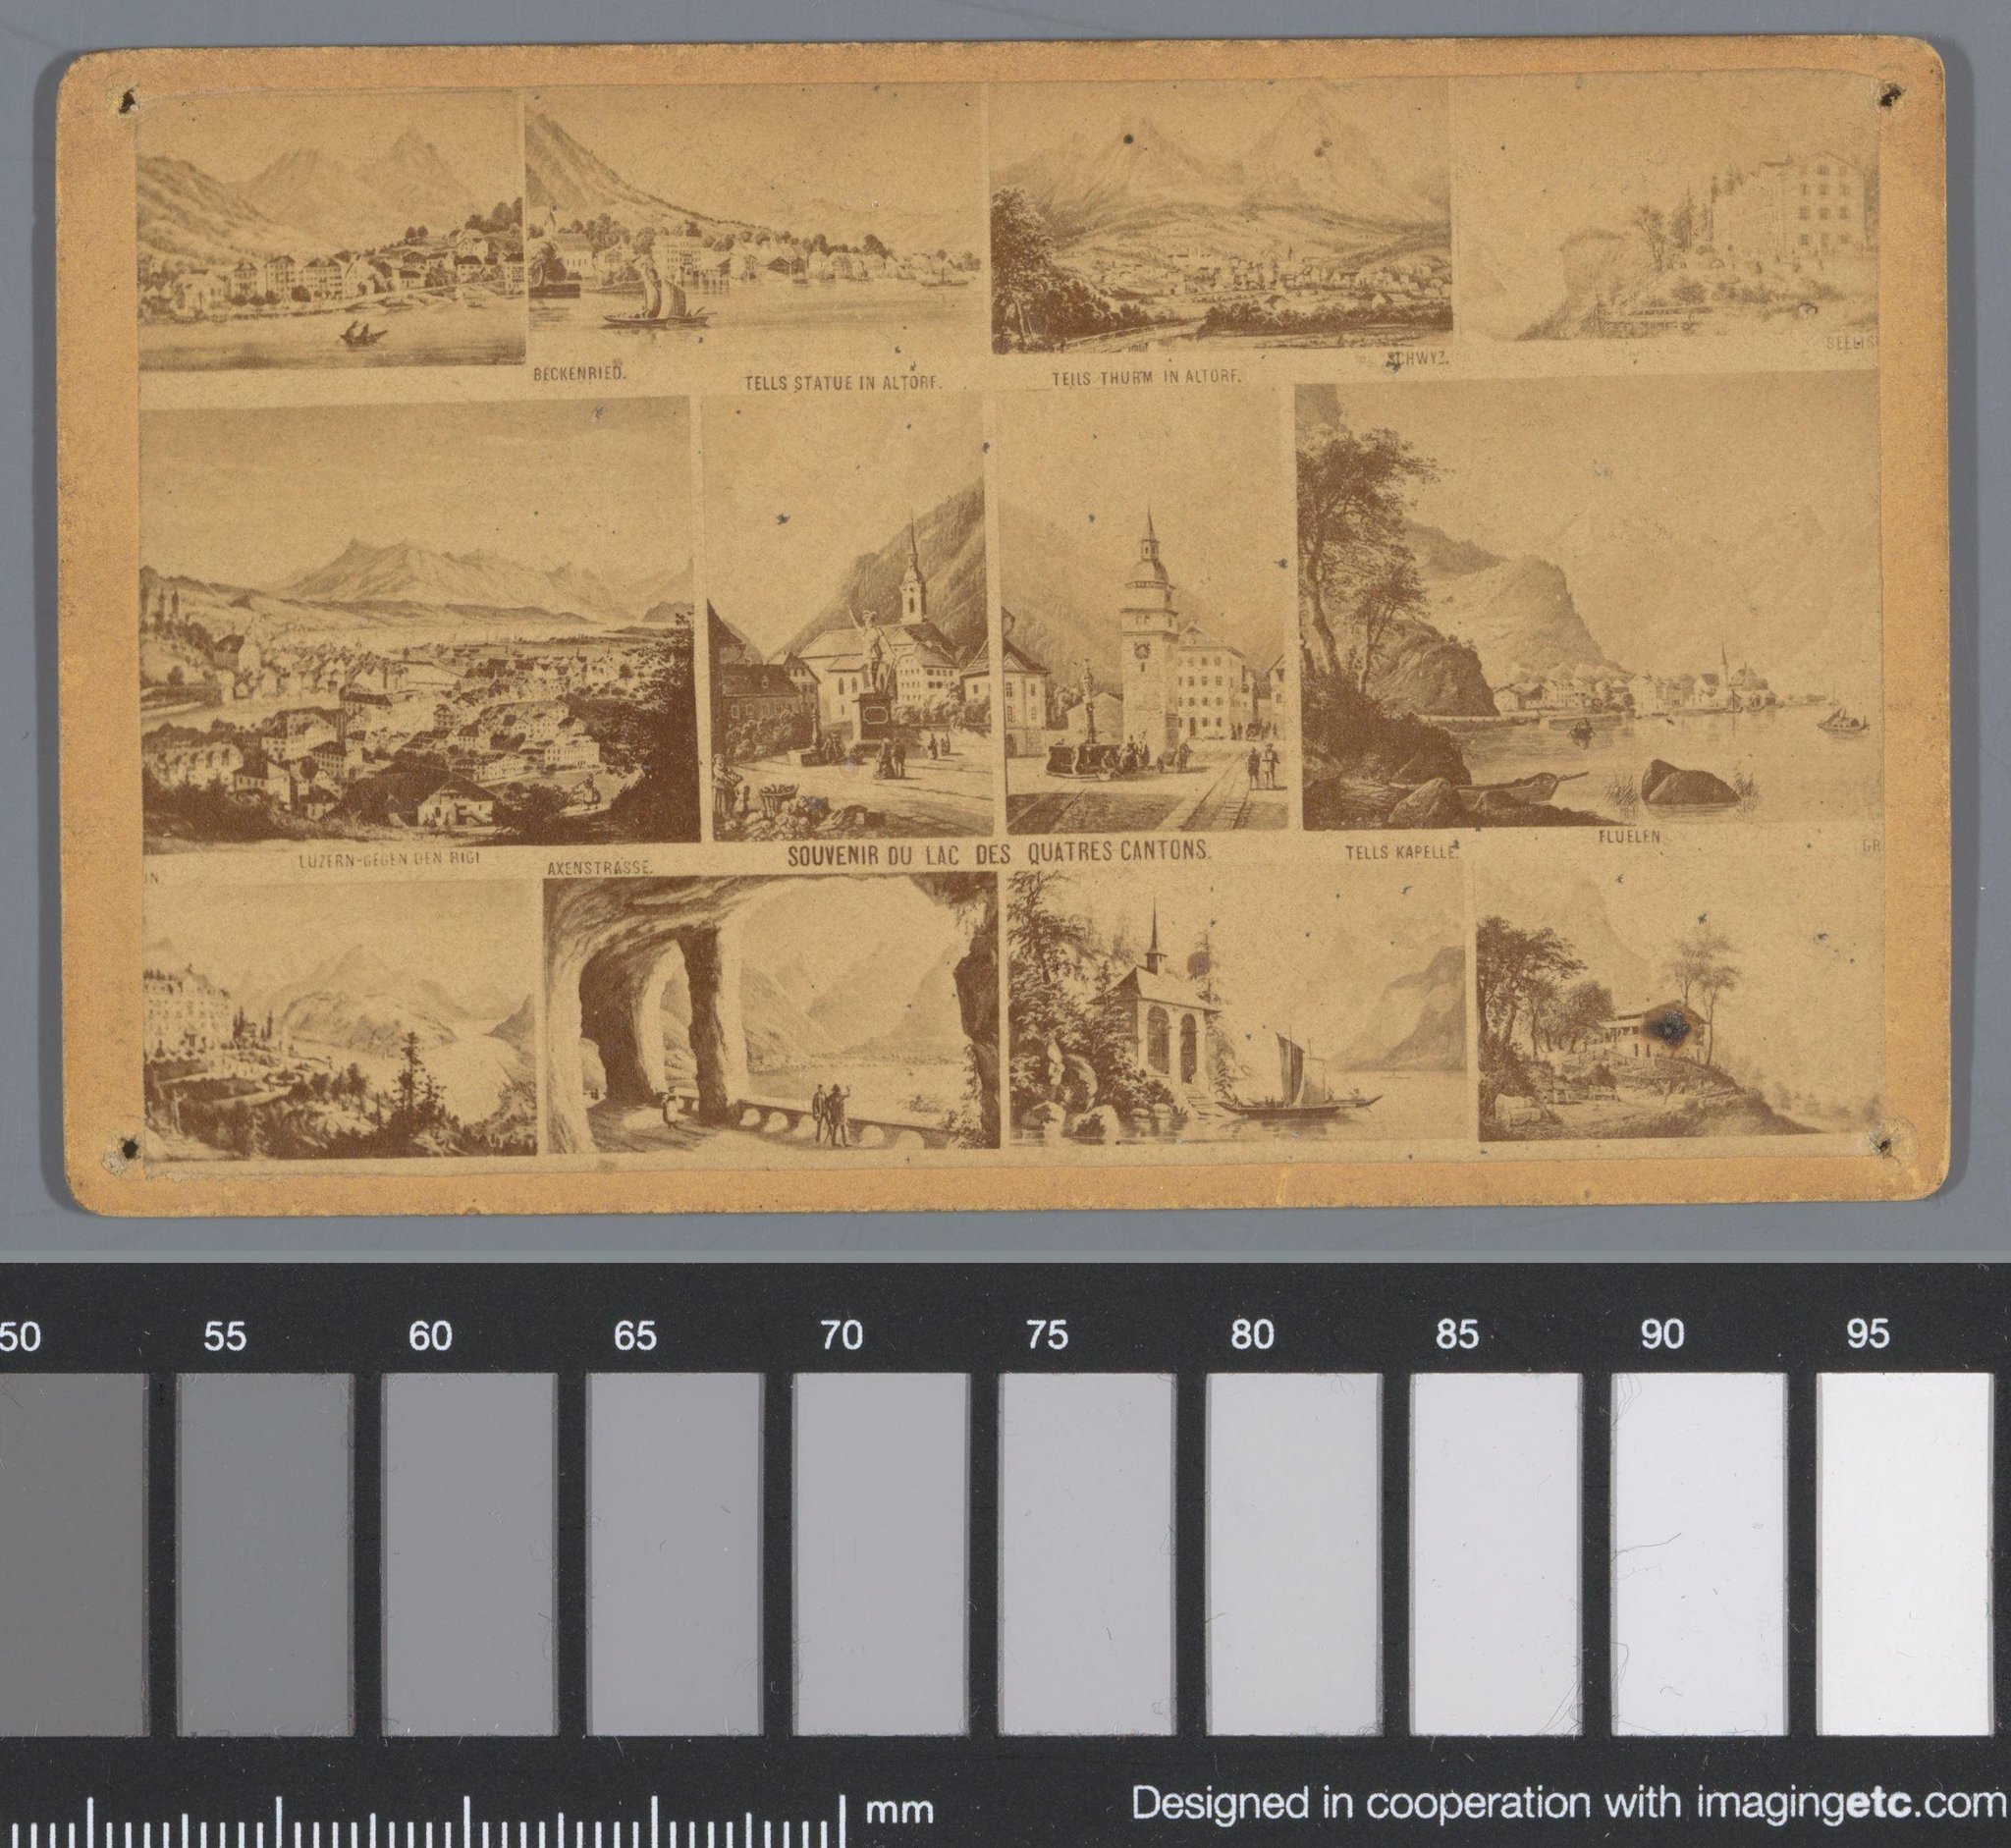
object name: carte de visite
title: Fotoreproductie van twaalf tekeningen van gezichten rondom het Vierwoudstrekenmeer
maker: Anonymous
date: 1854-1885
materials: cardboard, paper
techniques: albumen print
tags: city-view in general; 'veduta', painting, drawing and the graphic arts